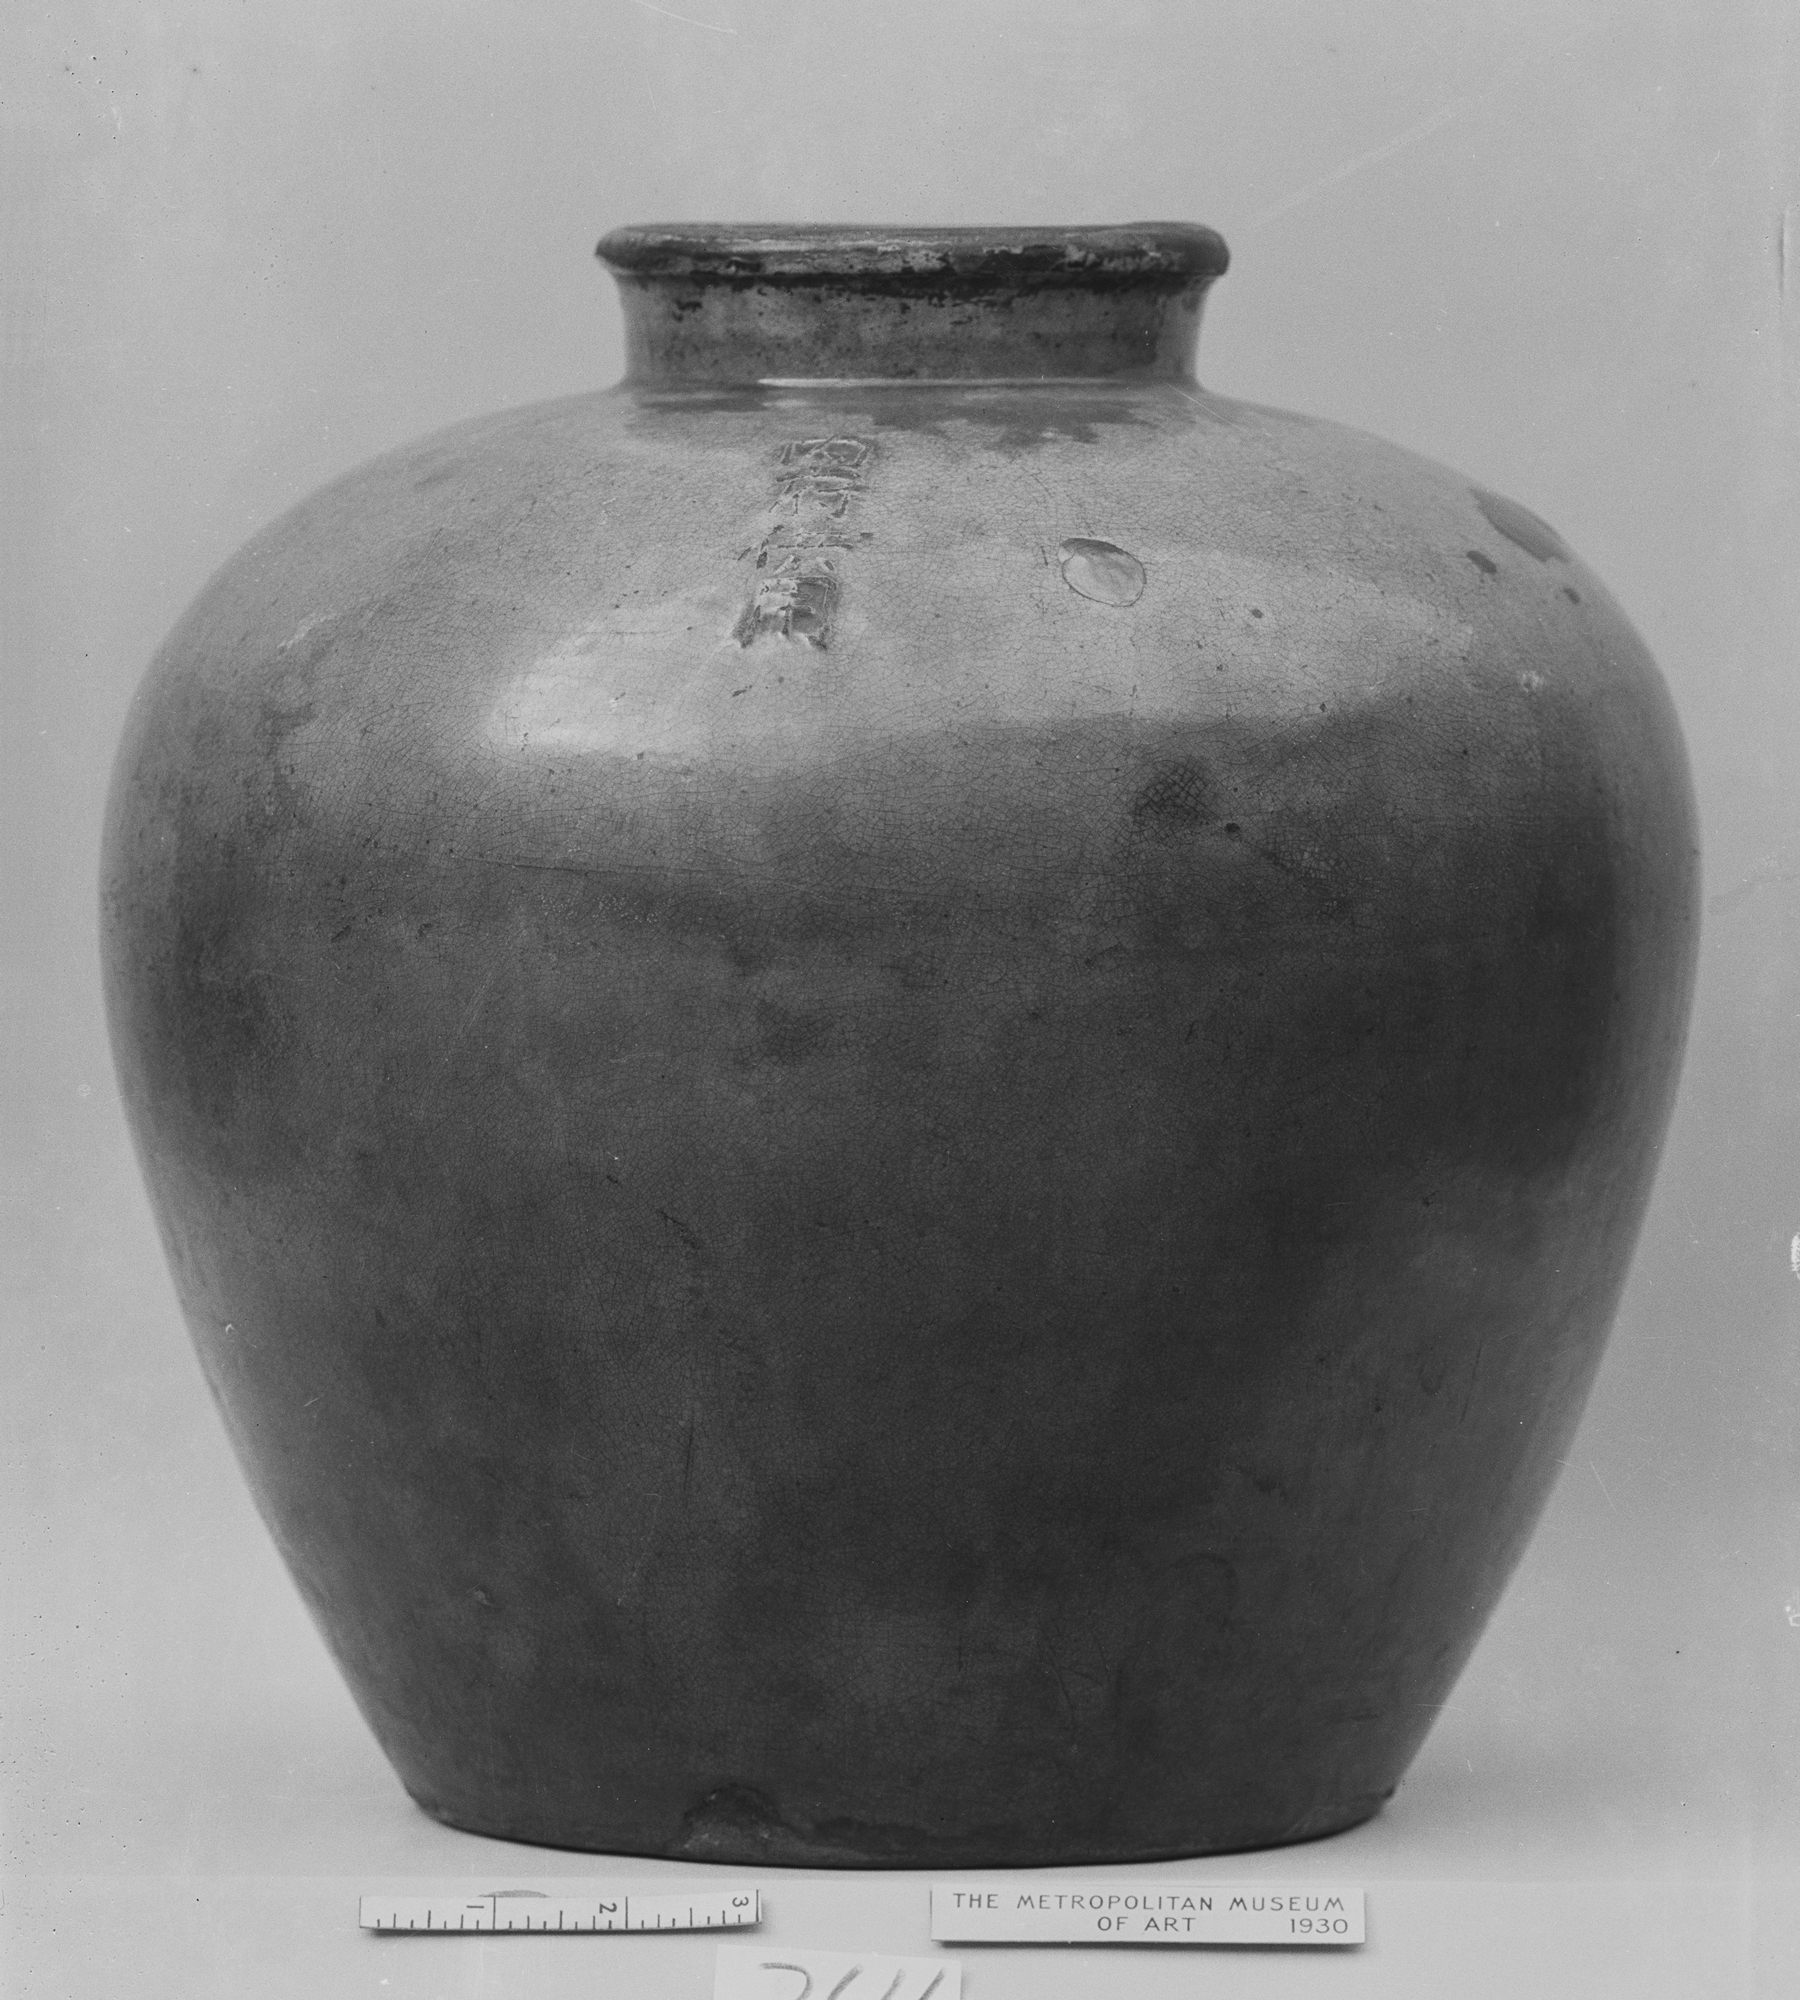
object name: jar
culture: chinese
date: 1271-1368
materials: stoneware